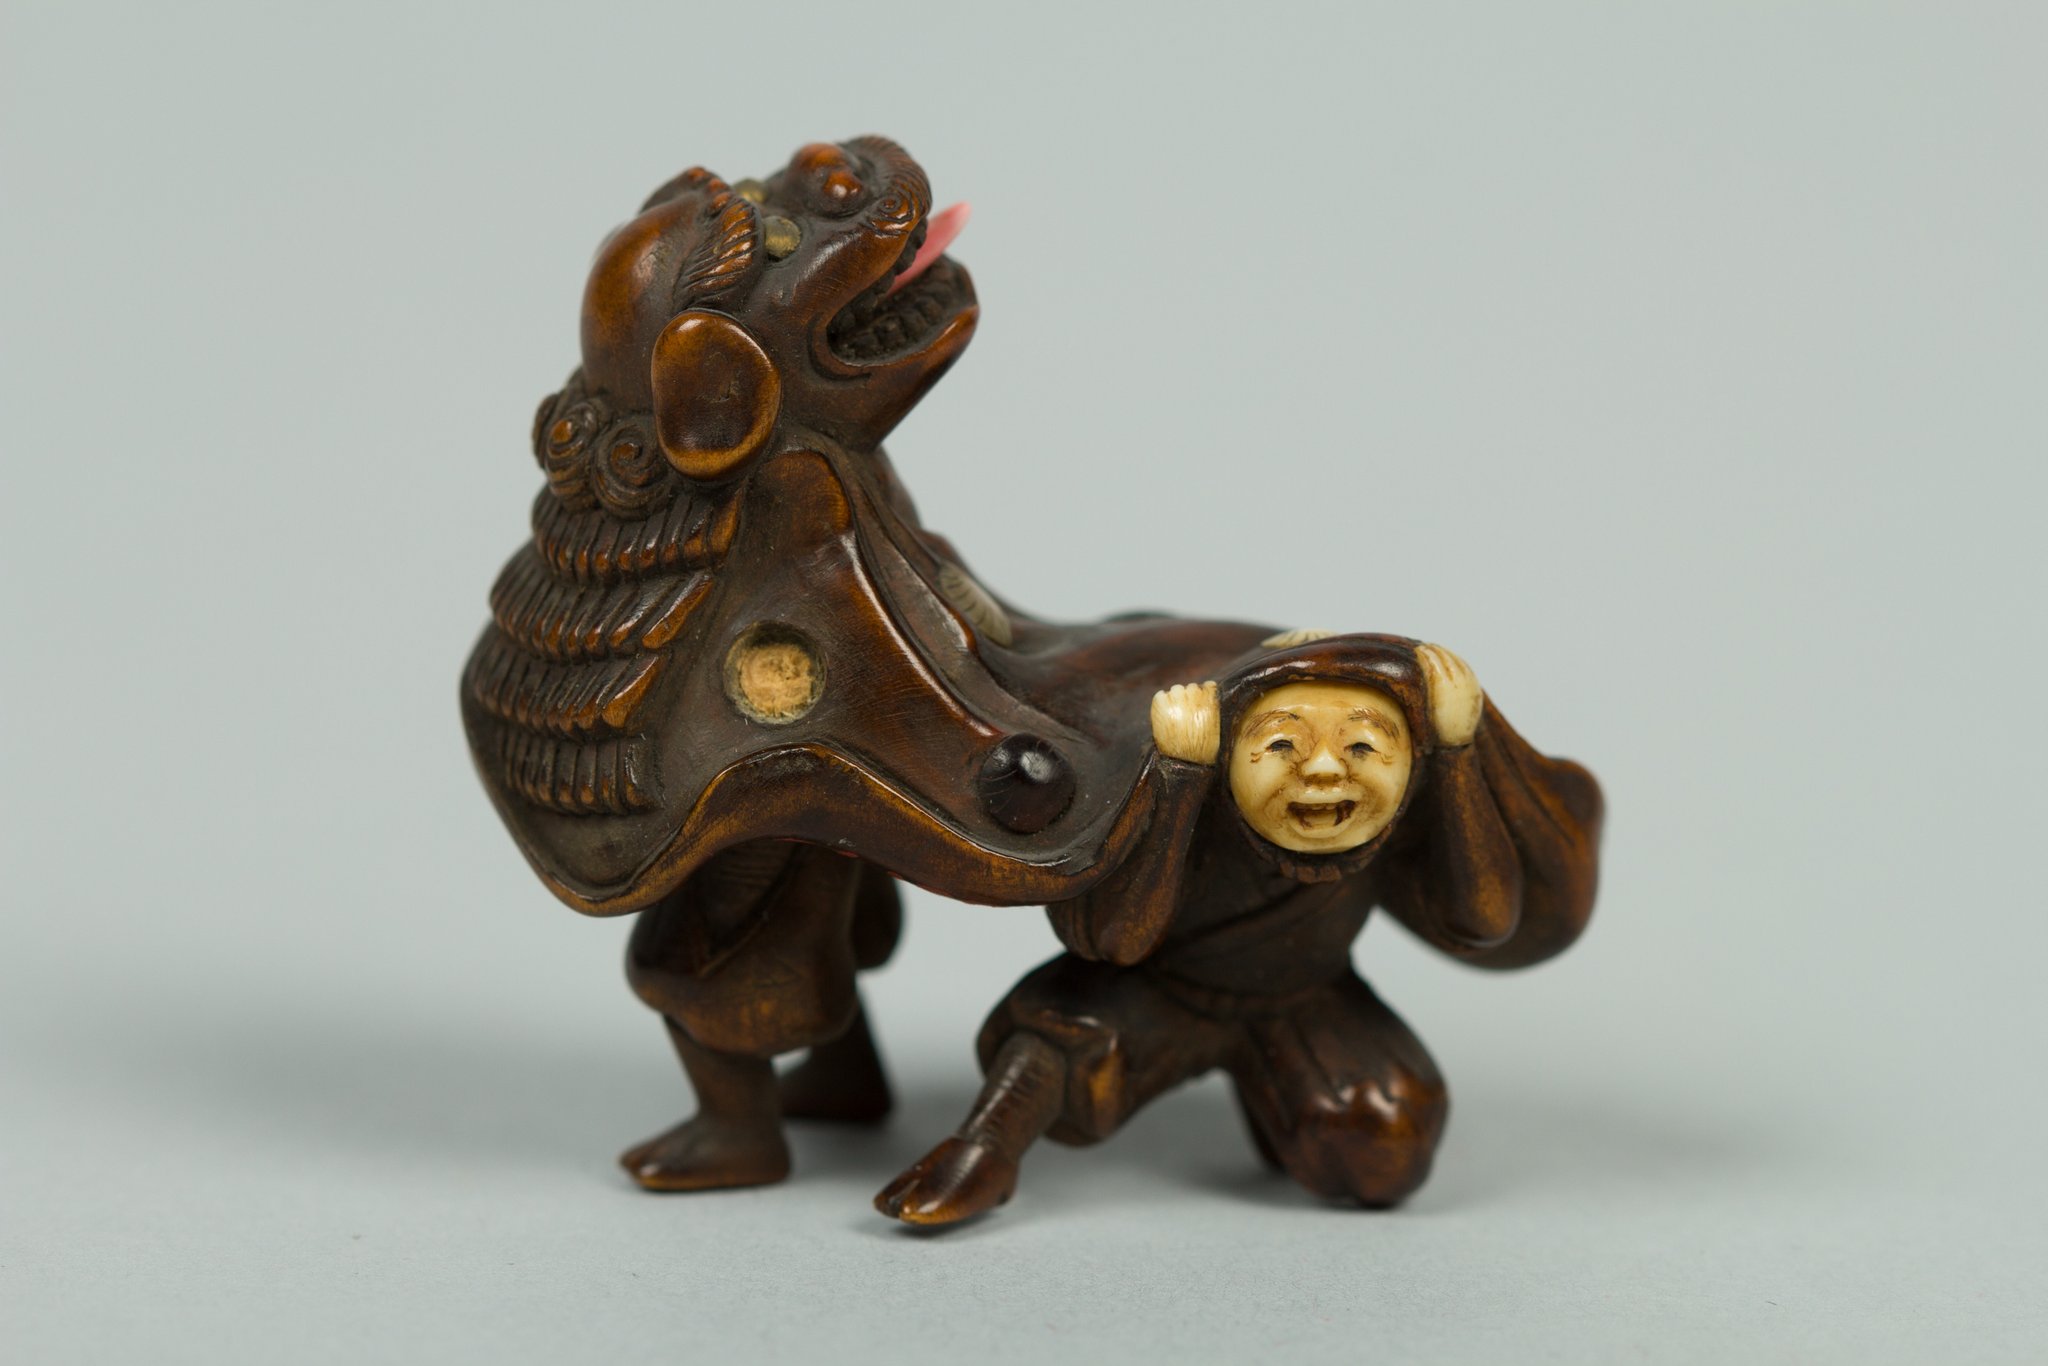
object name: netsuke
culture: japanese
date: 1801-1900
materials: ivory, wood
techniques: inlay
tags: human figures,dragons